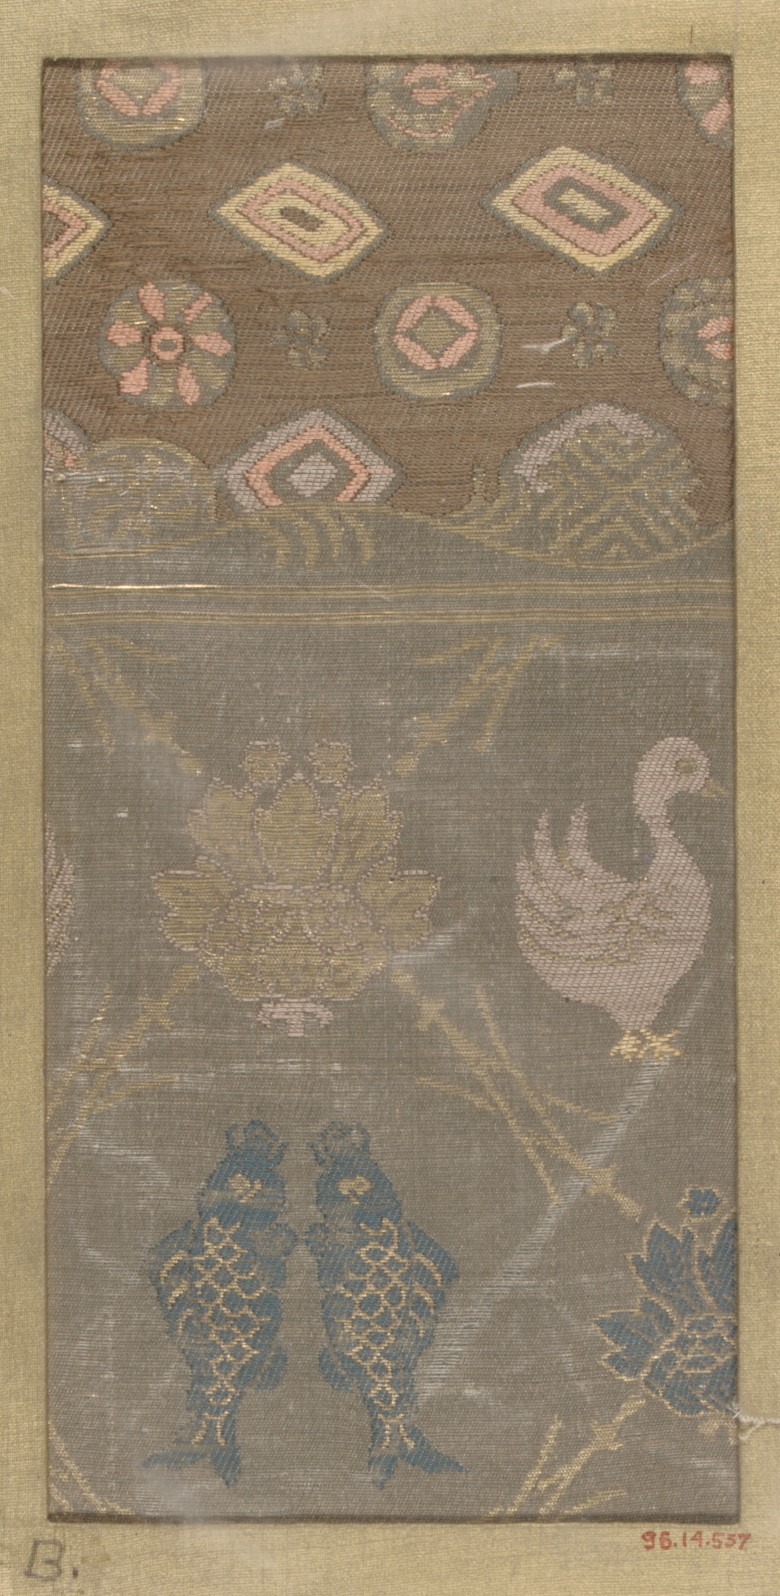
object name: piece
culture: japanese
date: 1701-1900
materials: silk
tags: ducks,fish